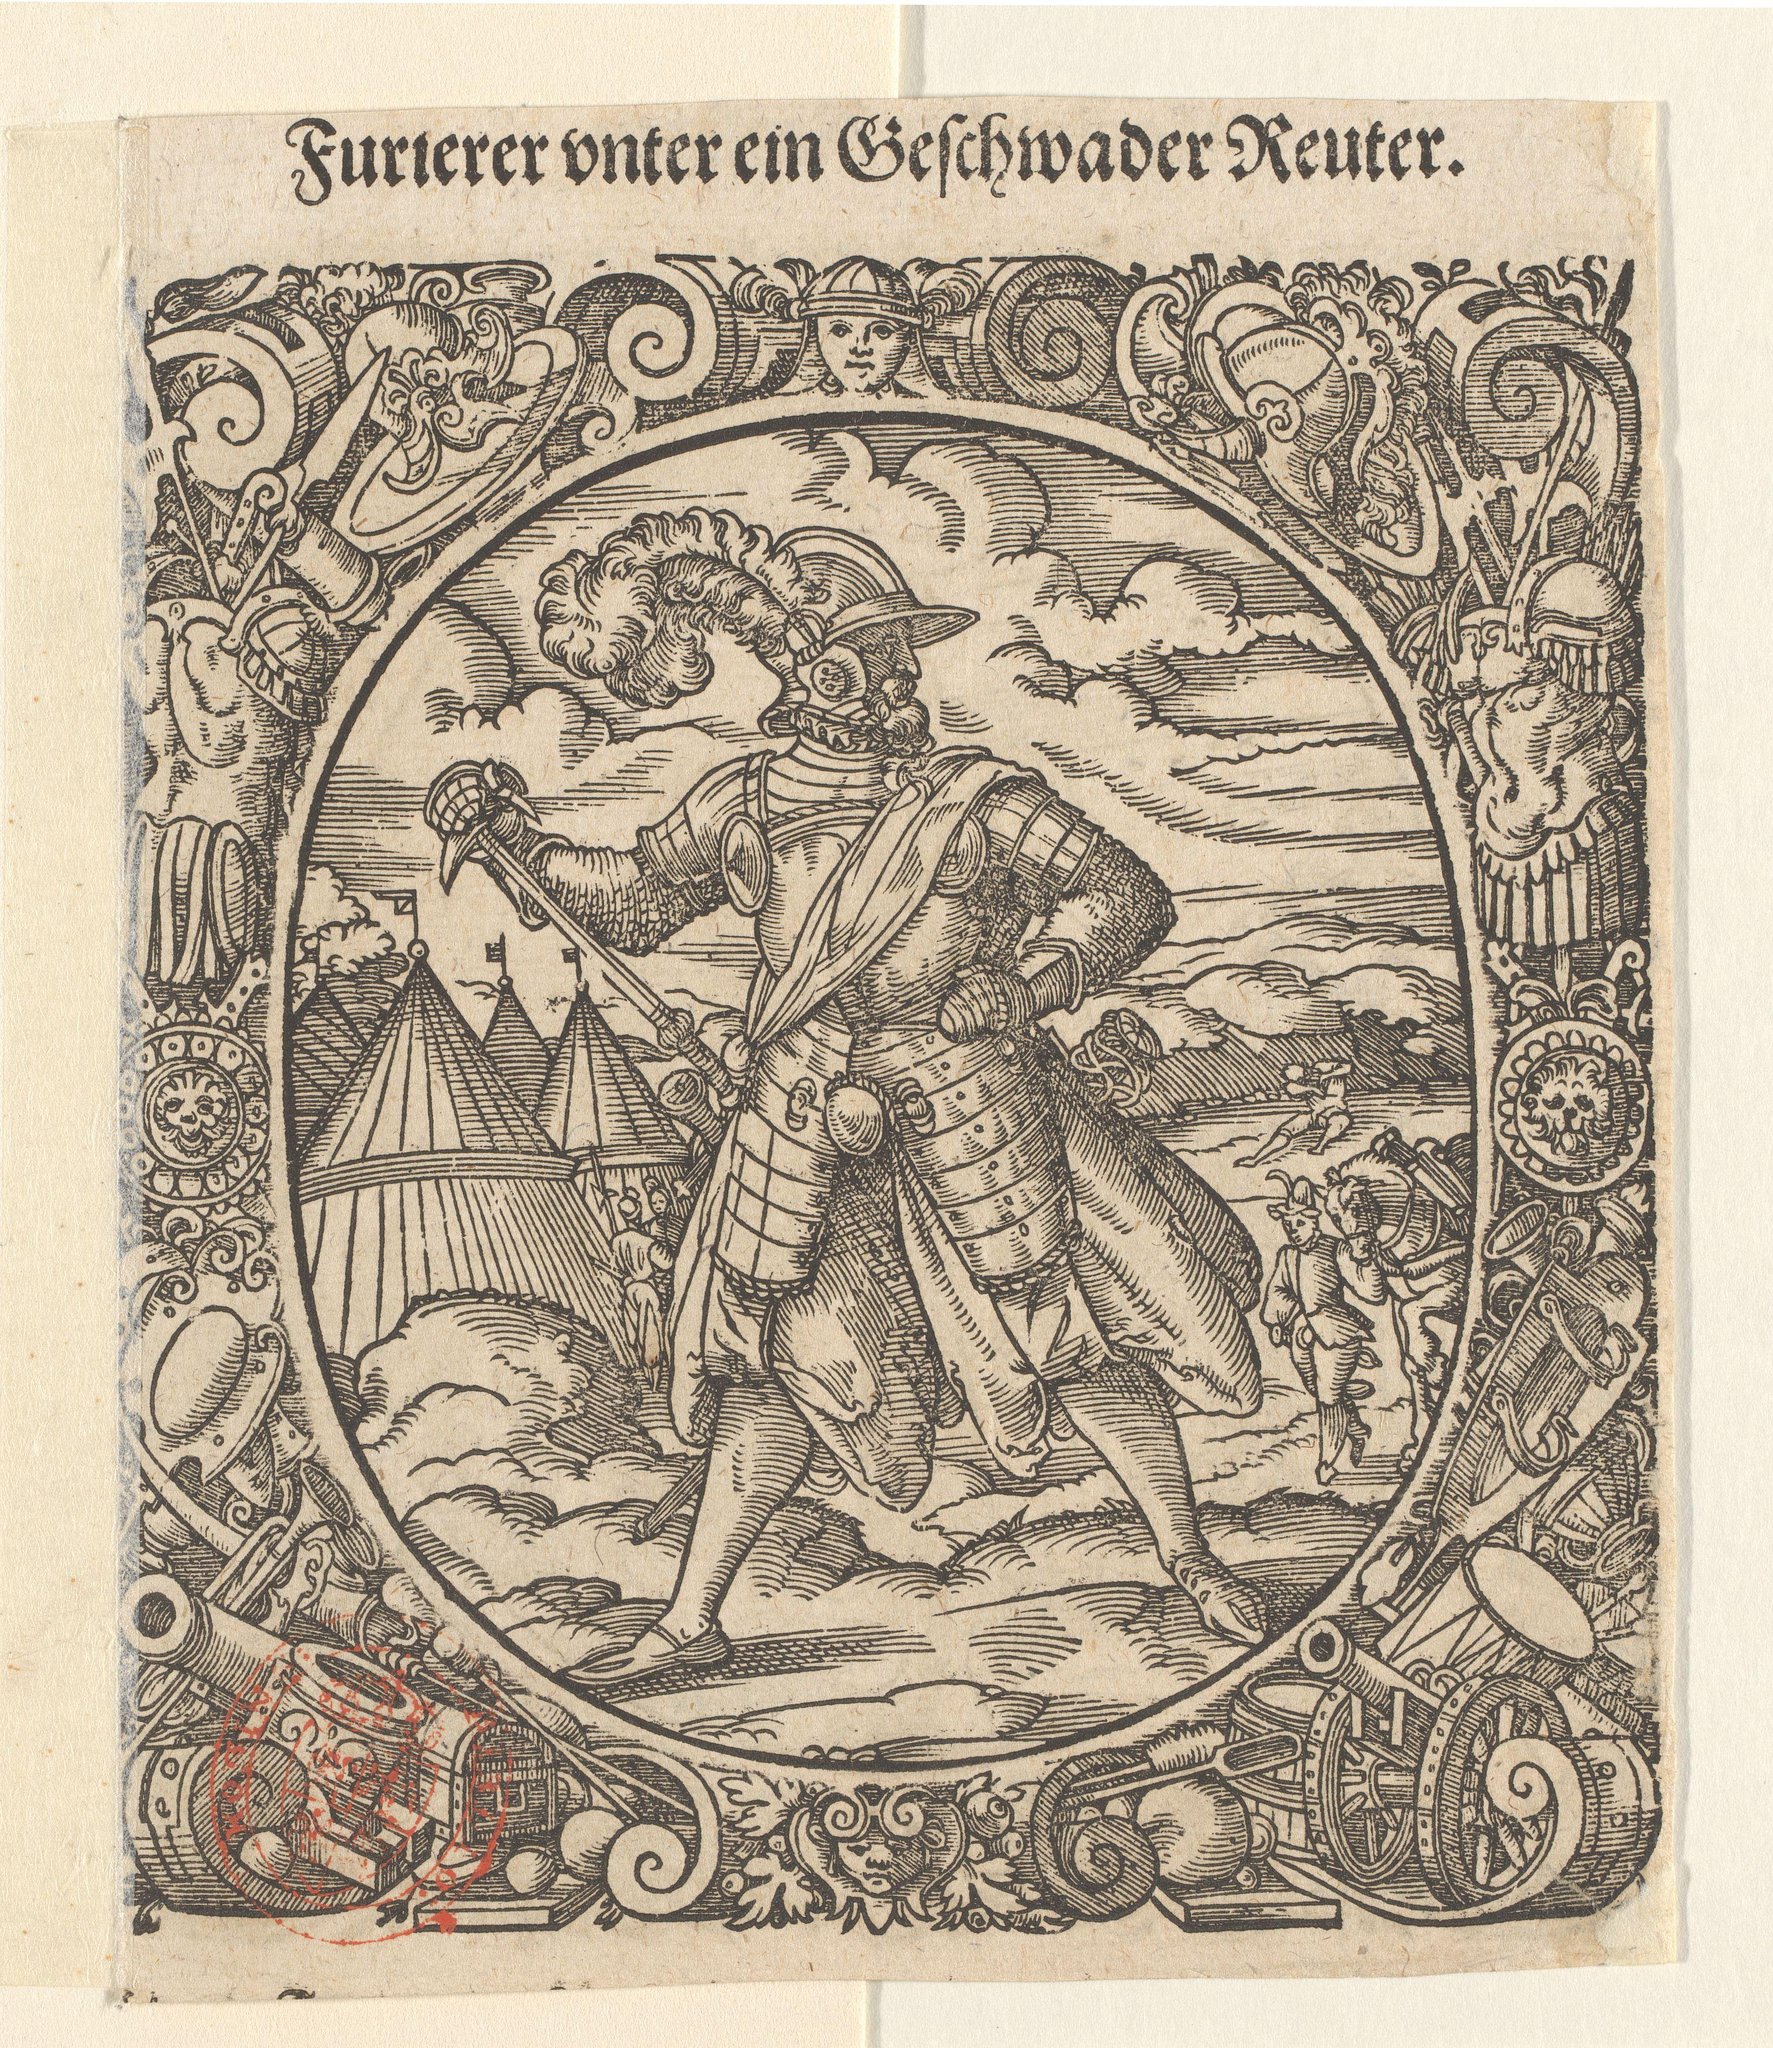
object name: print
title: Furierer unter ein Geschwader Reuter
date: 1573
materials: paper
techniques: woodcut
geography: frankfurt am main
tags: (military) camp with tents, armour, warfare; military affairs, the soldier; the soldier's life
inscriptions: collector's mark: Lugt 240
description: Zowel de voorstelling als de ornamentrand werd gebruikt voor verschillende edities van Leonhardt Fronspergers Kriegsbuch.